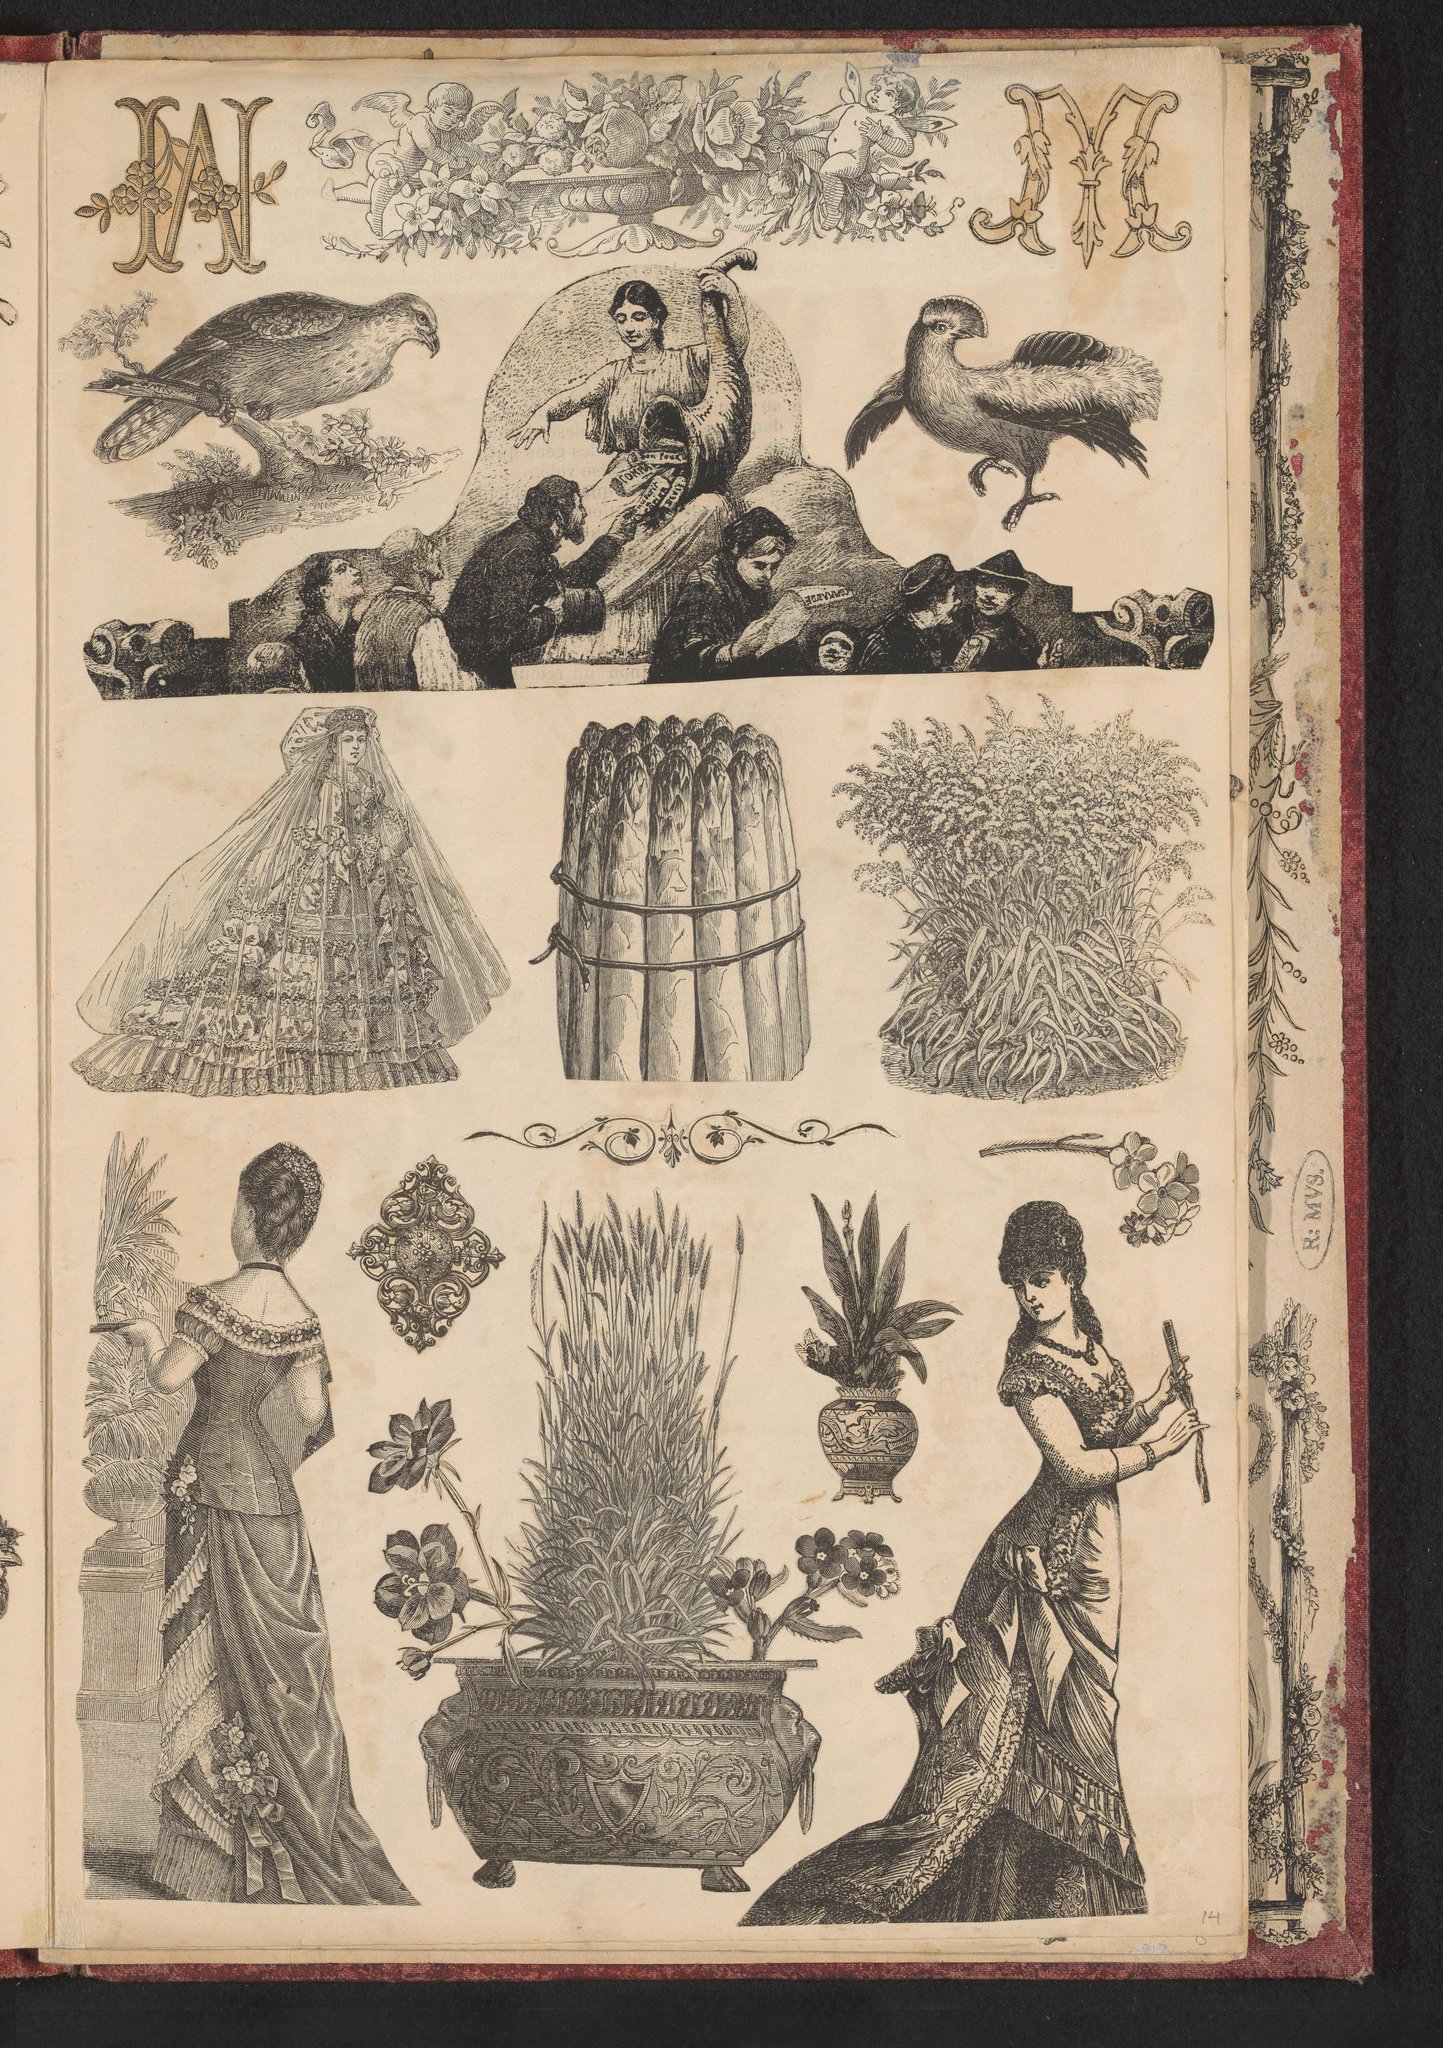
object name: collage visual work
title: Collage van uitgeknipte prenten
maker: Anonymous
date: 1870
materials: paper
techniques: engraving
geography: paris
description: Collage van uitgeknipte prenten. Onderdeel van een album met 32 bladen, aan beide zijden beplakt met uitgeknipte prenten, vermoedelijk afkomstig uit 19e-eeuwse tijdschiften.